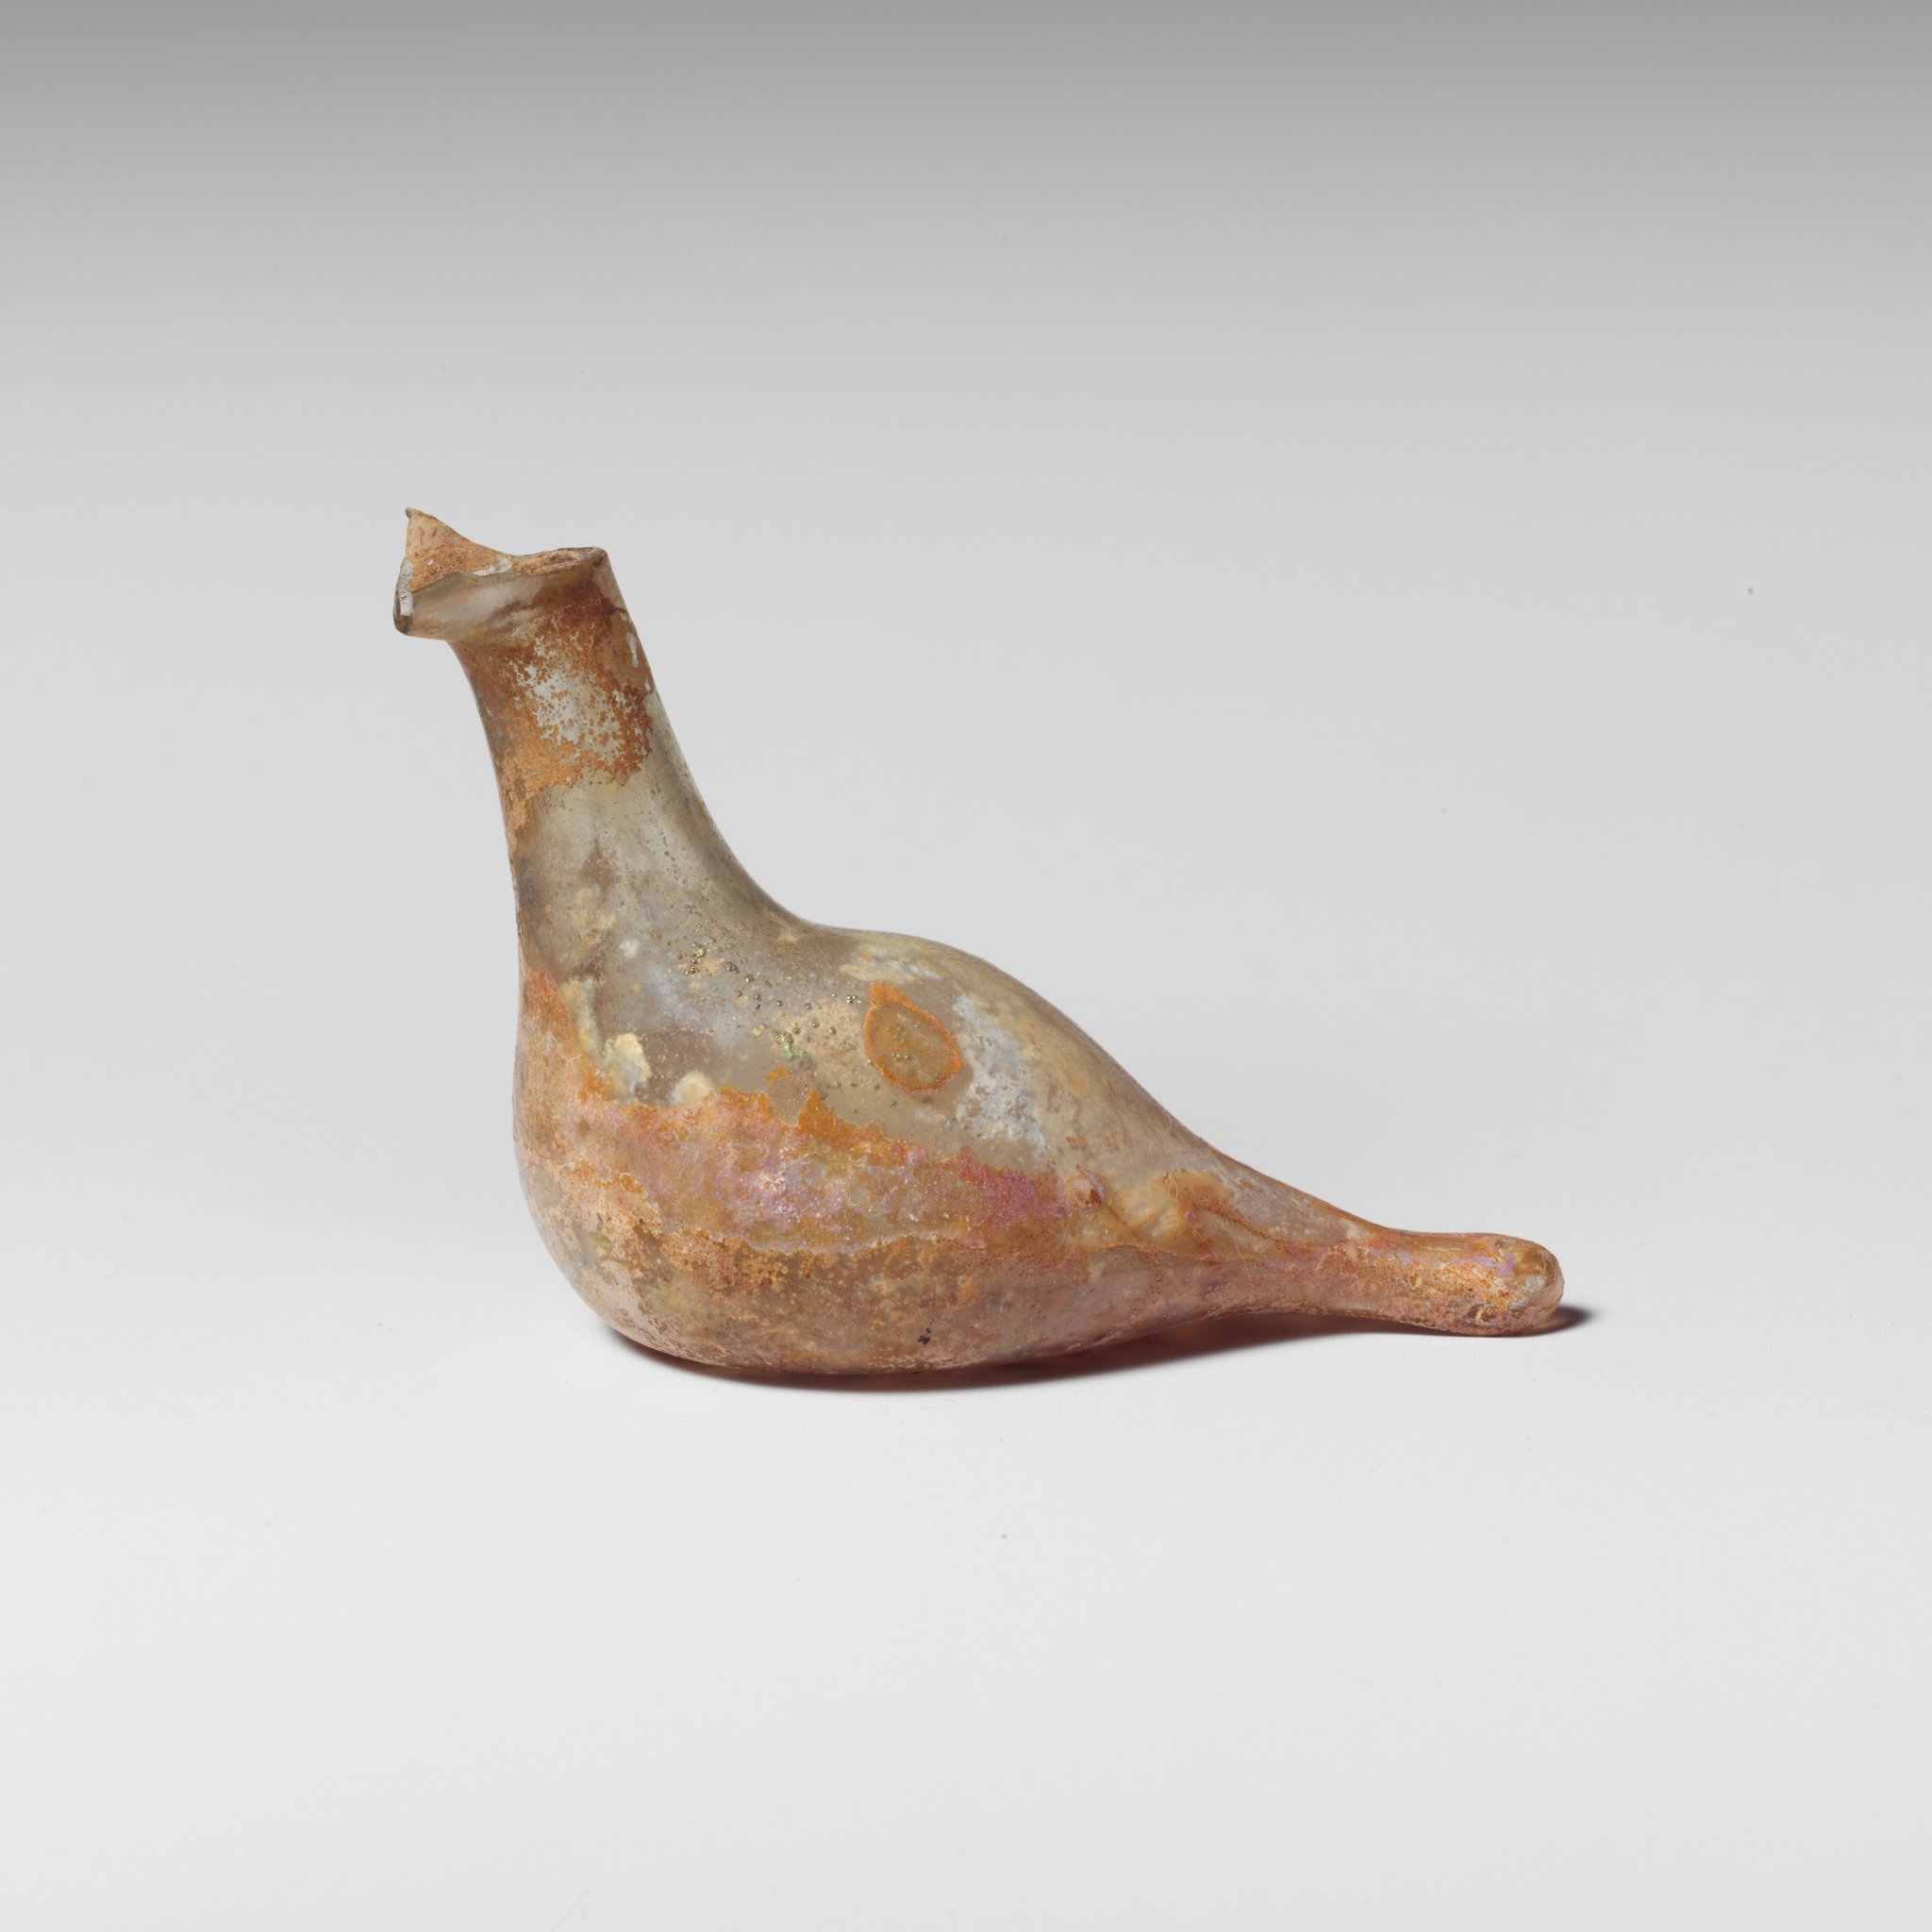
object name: bottle in the form of a bird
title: Glass bottle shaped like a bird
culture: roman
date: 1-300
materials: glass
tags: birds